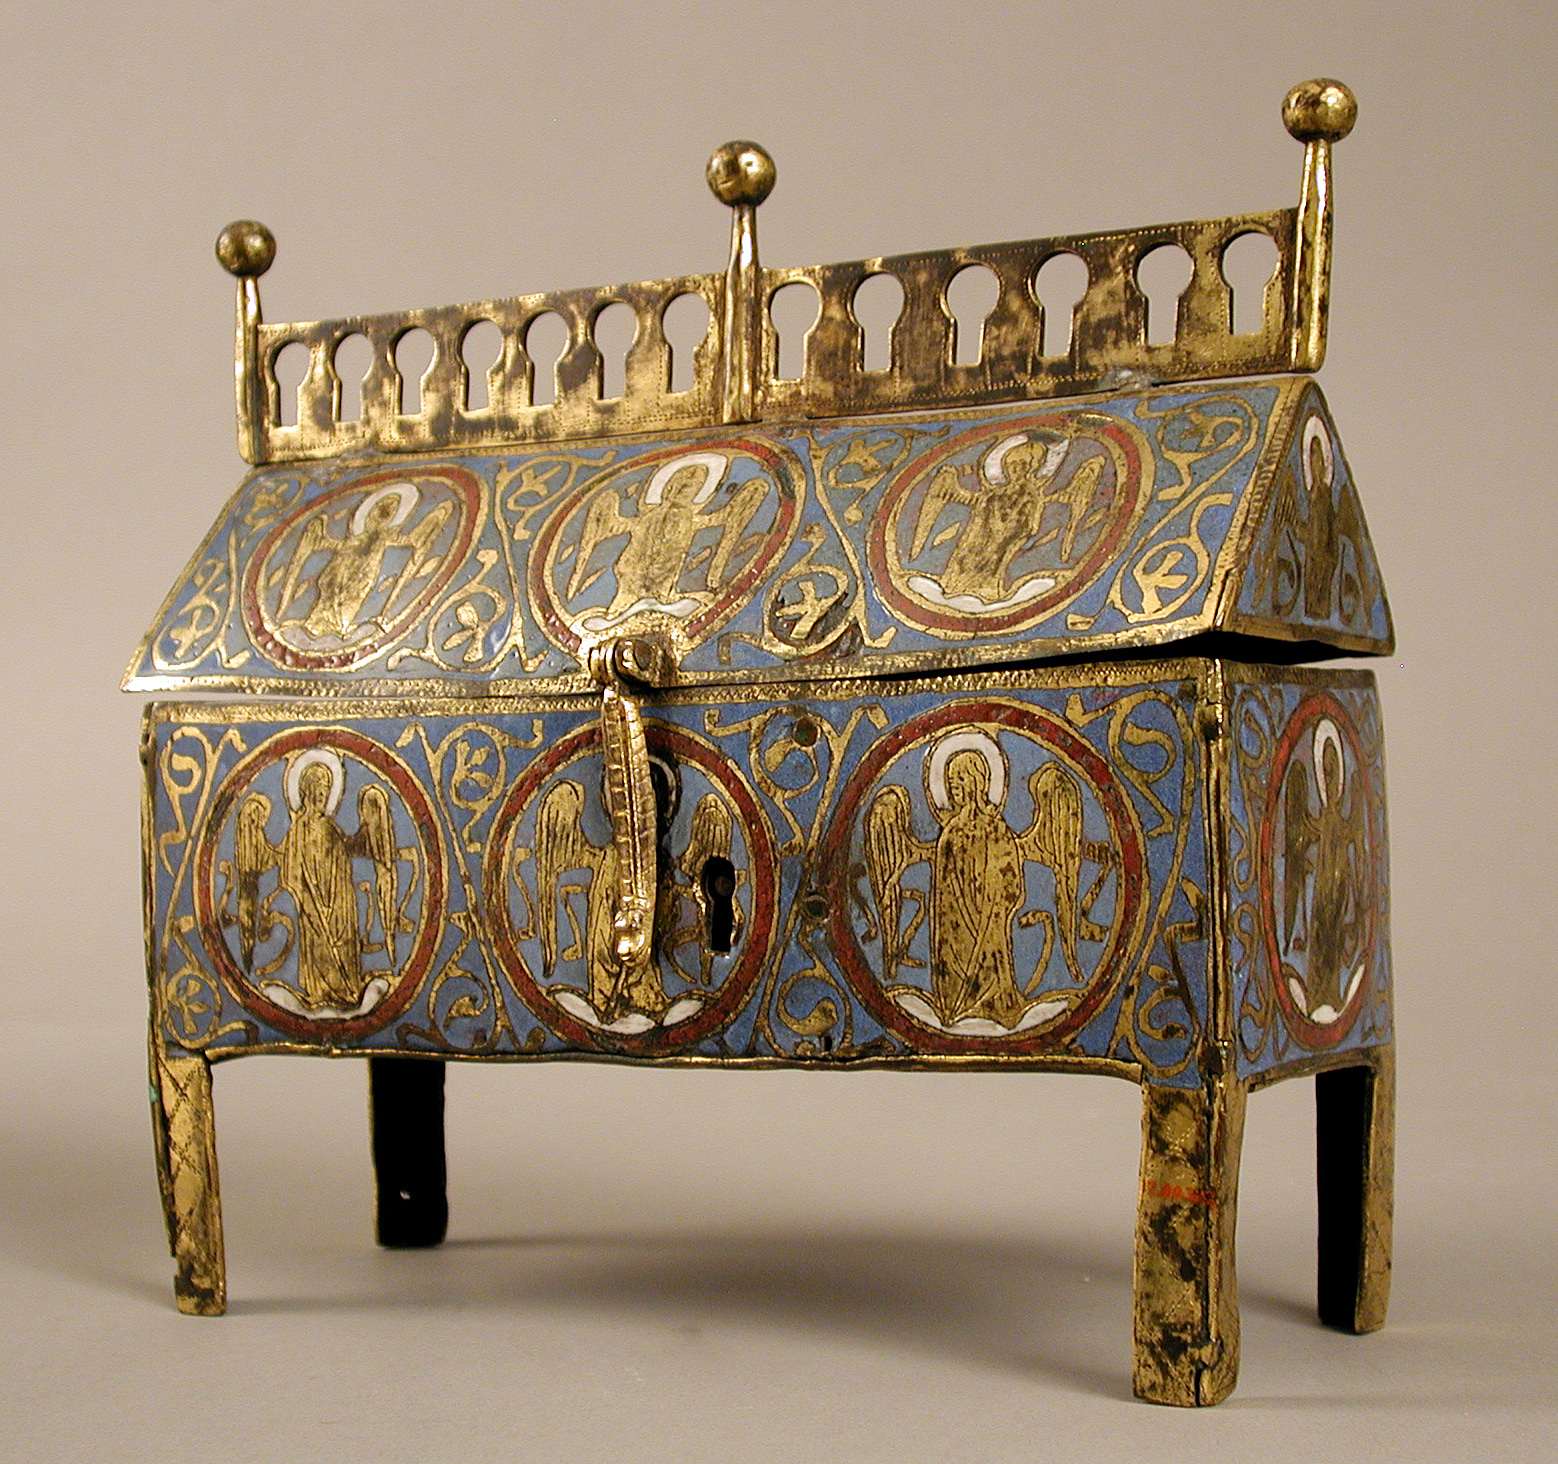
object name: chasse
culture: french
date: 1201-1300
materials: gilt copper, enamel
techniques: enamel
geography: france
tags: reliquaries